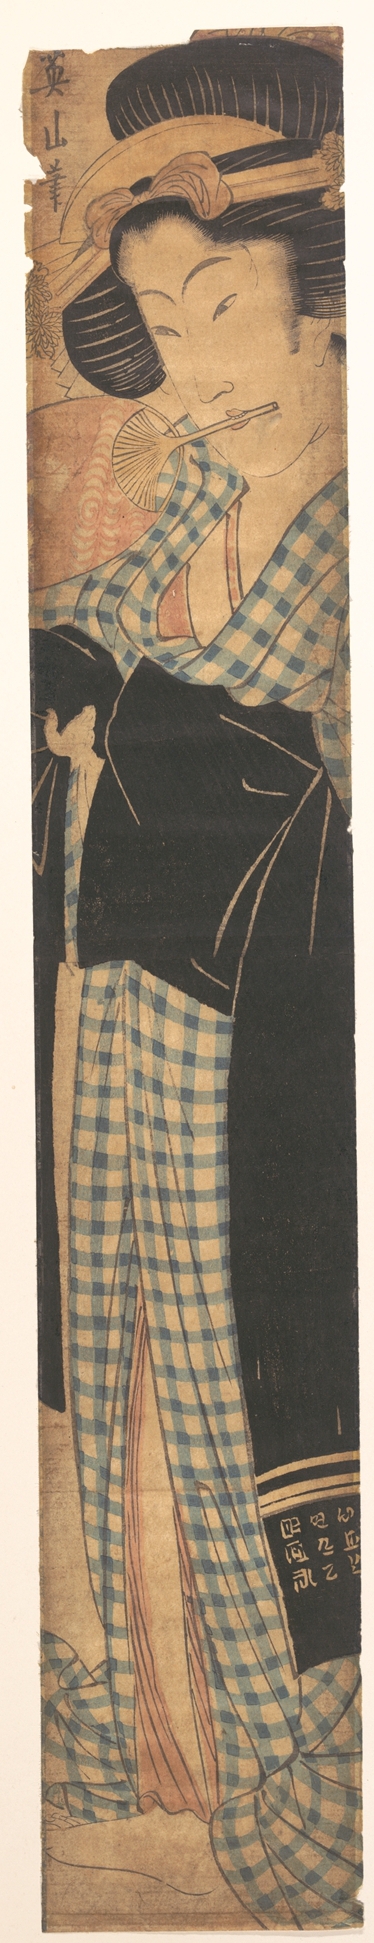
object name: print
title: Two Geisha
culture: japanese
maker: kikugawa eizan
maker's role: artist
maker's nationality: japanese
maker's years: 1787-1867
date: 1787-1867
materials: ink, paper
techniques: woodblock print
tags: women